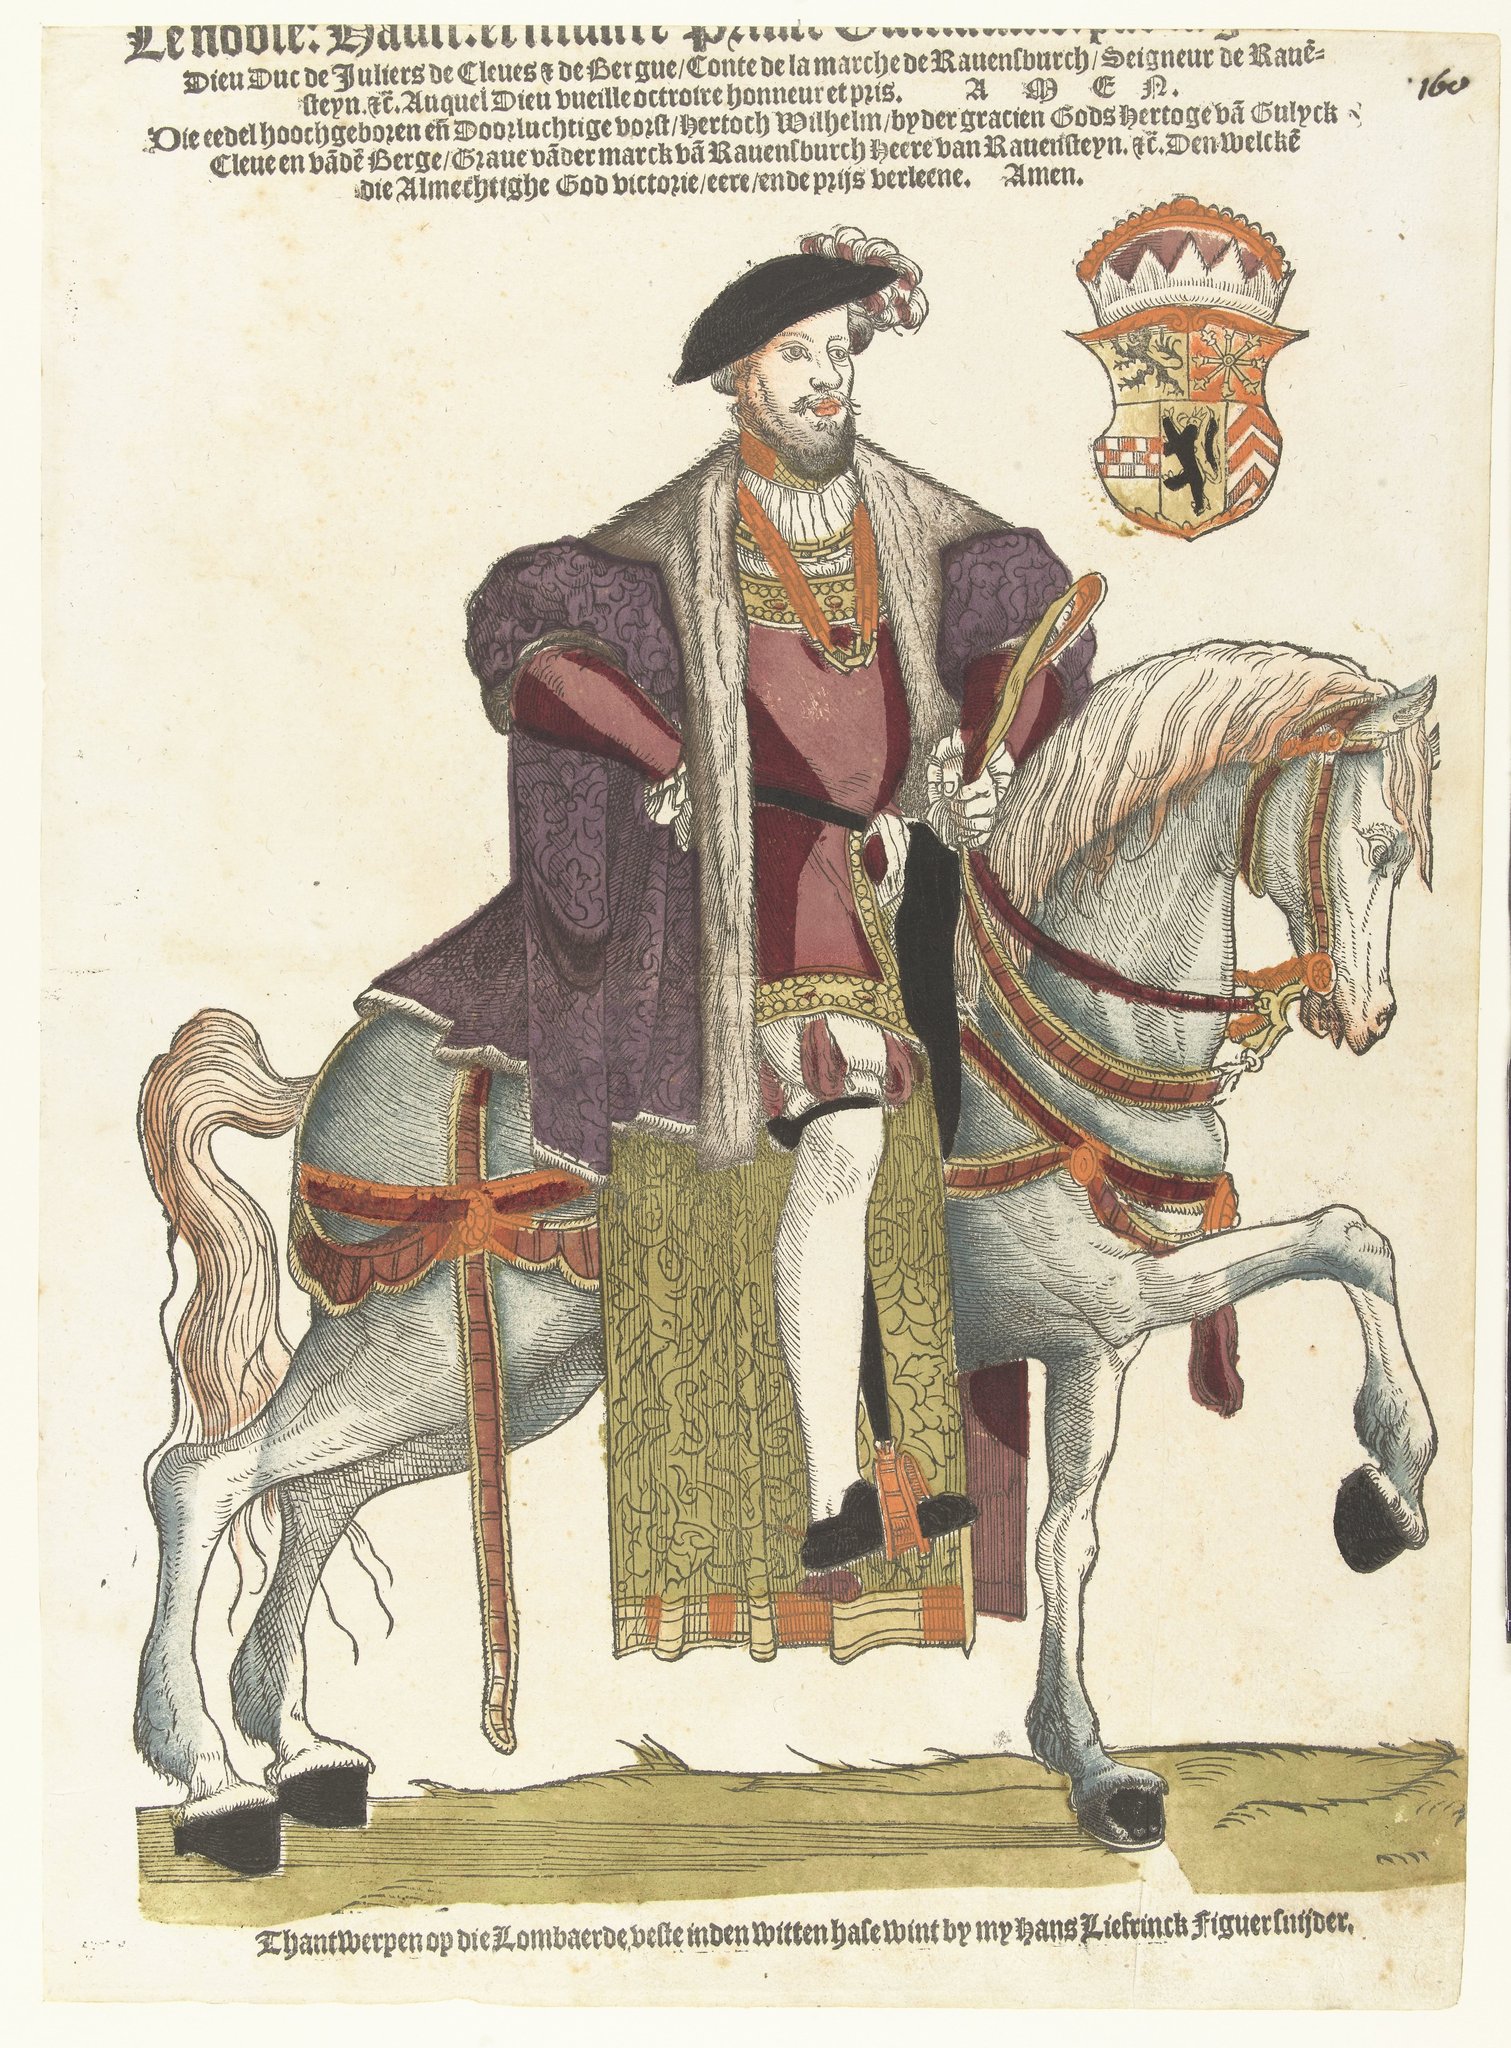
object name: print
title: Portret van hertog Willem van Kleef, Gulik en Berg, graaf van Mark, heer van Ravenstein te paard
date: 1543-1573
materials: paper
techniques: hand coloring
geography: antwerp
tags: equestrian state-portrait, historical persons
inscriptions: number: ‘160’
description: Willem van Gulik, hertog van Gelre, gekleed in Spaanse hofdracht te paard. Rechtsboven het wapenschild. Bovenaan tekst in het Frans en in het Nederlands.